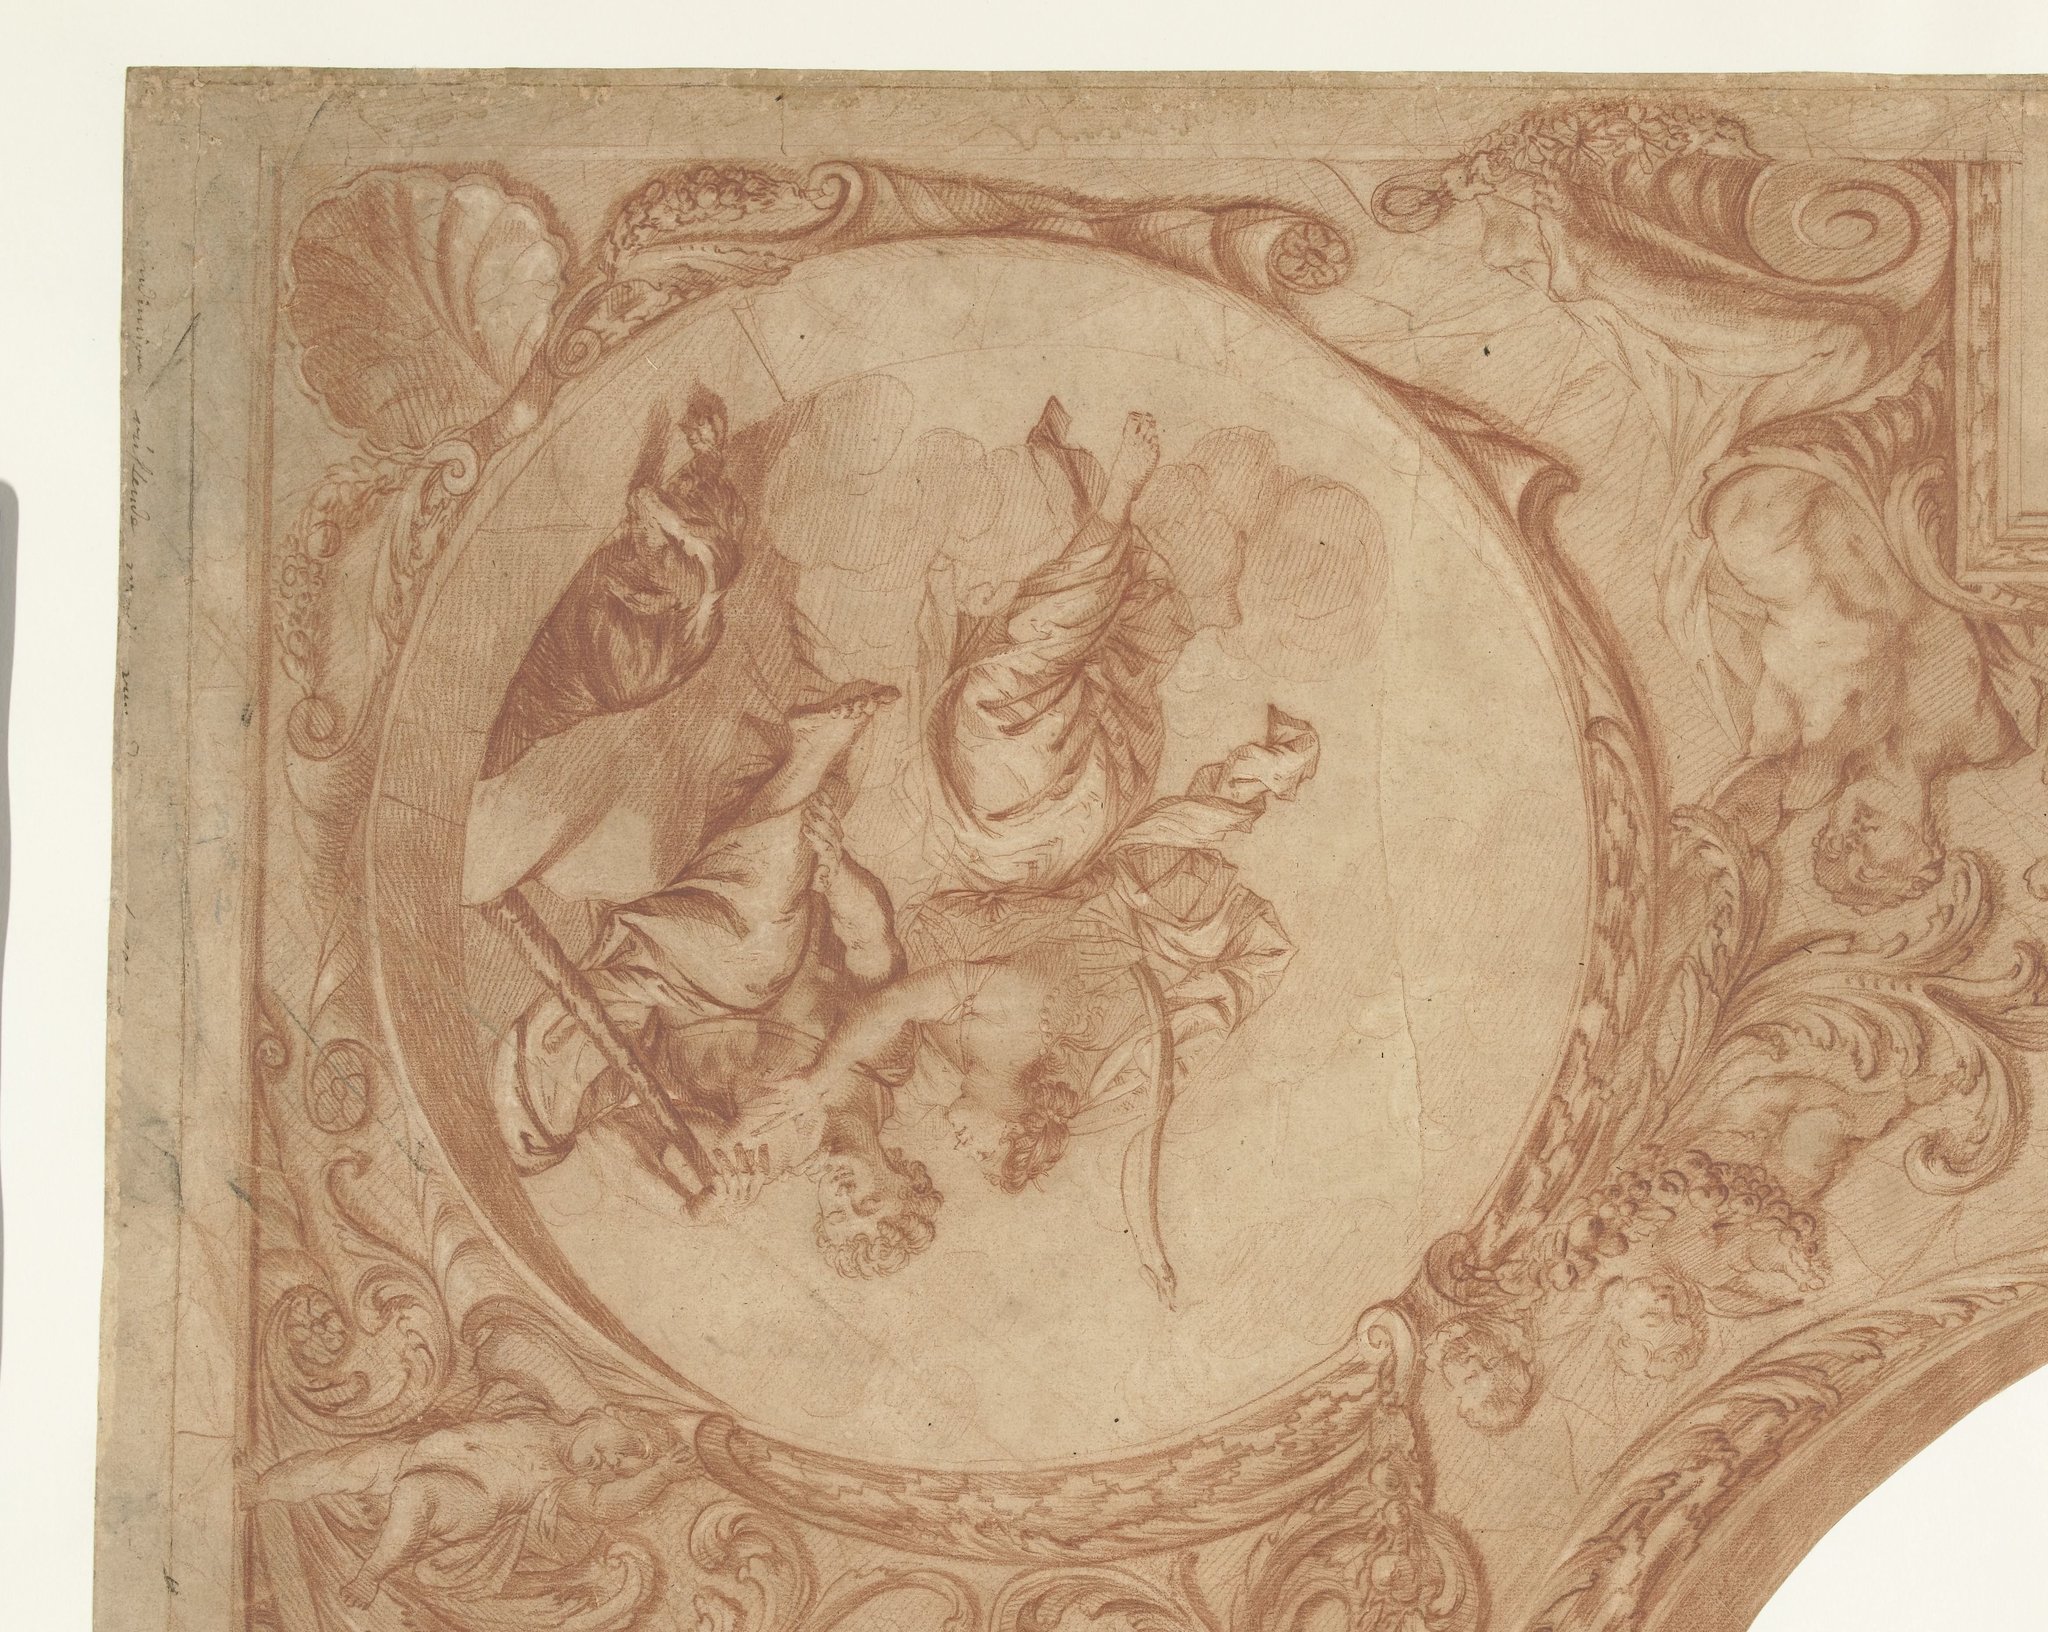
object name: design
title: Ontwerp voor een hoekstuk van een plafond met Diana en Endymion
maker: mattheus terwesten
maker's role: draughtsman, painter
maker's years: 1670-1757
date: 1680-1757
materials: chalk, paper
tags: diana (luna) visiting the sleeping endymion, acanthus ~ ornament, venus mourning adonis, (decorated) ceiling, cupids: 'amores', 'amoretti', 'putti'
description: Hoekstuk van een plafond met Diana en Endymion in een ronde cartouche; rechts de helft van een voorstelling van Venus treurend bij het lichaam van Adonis.